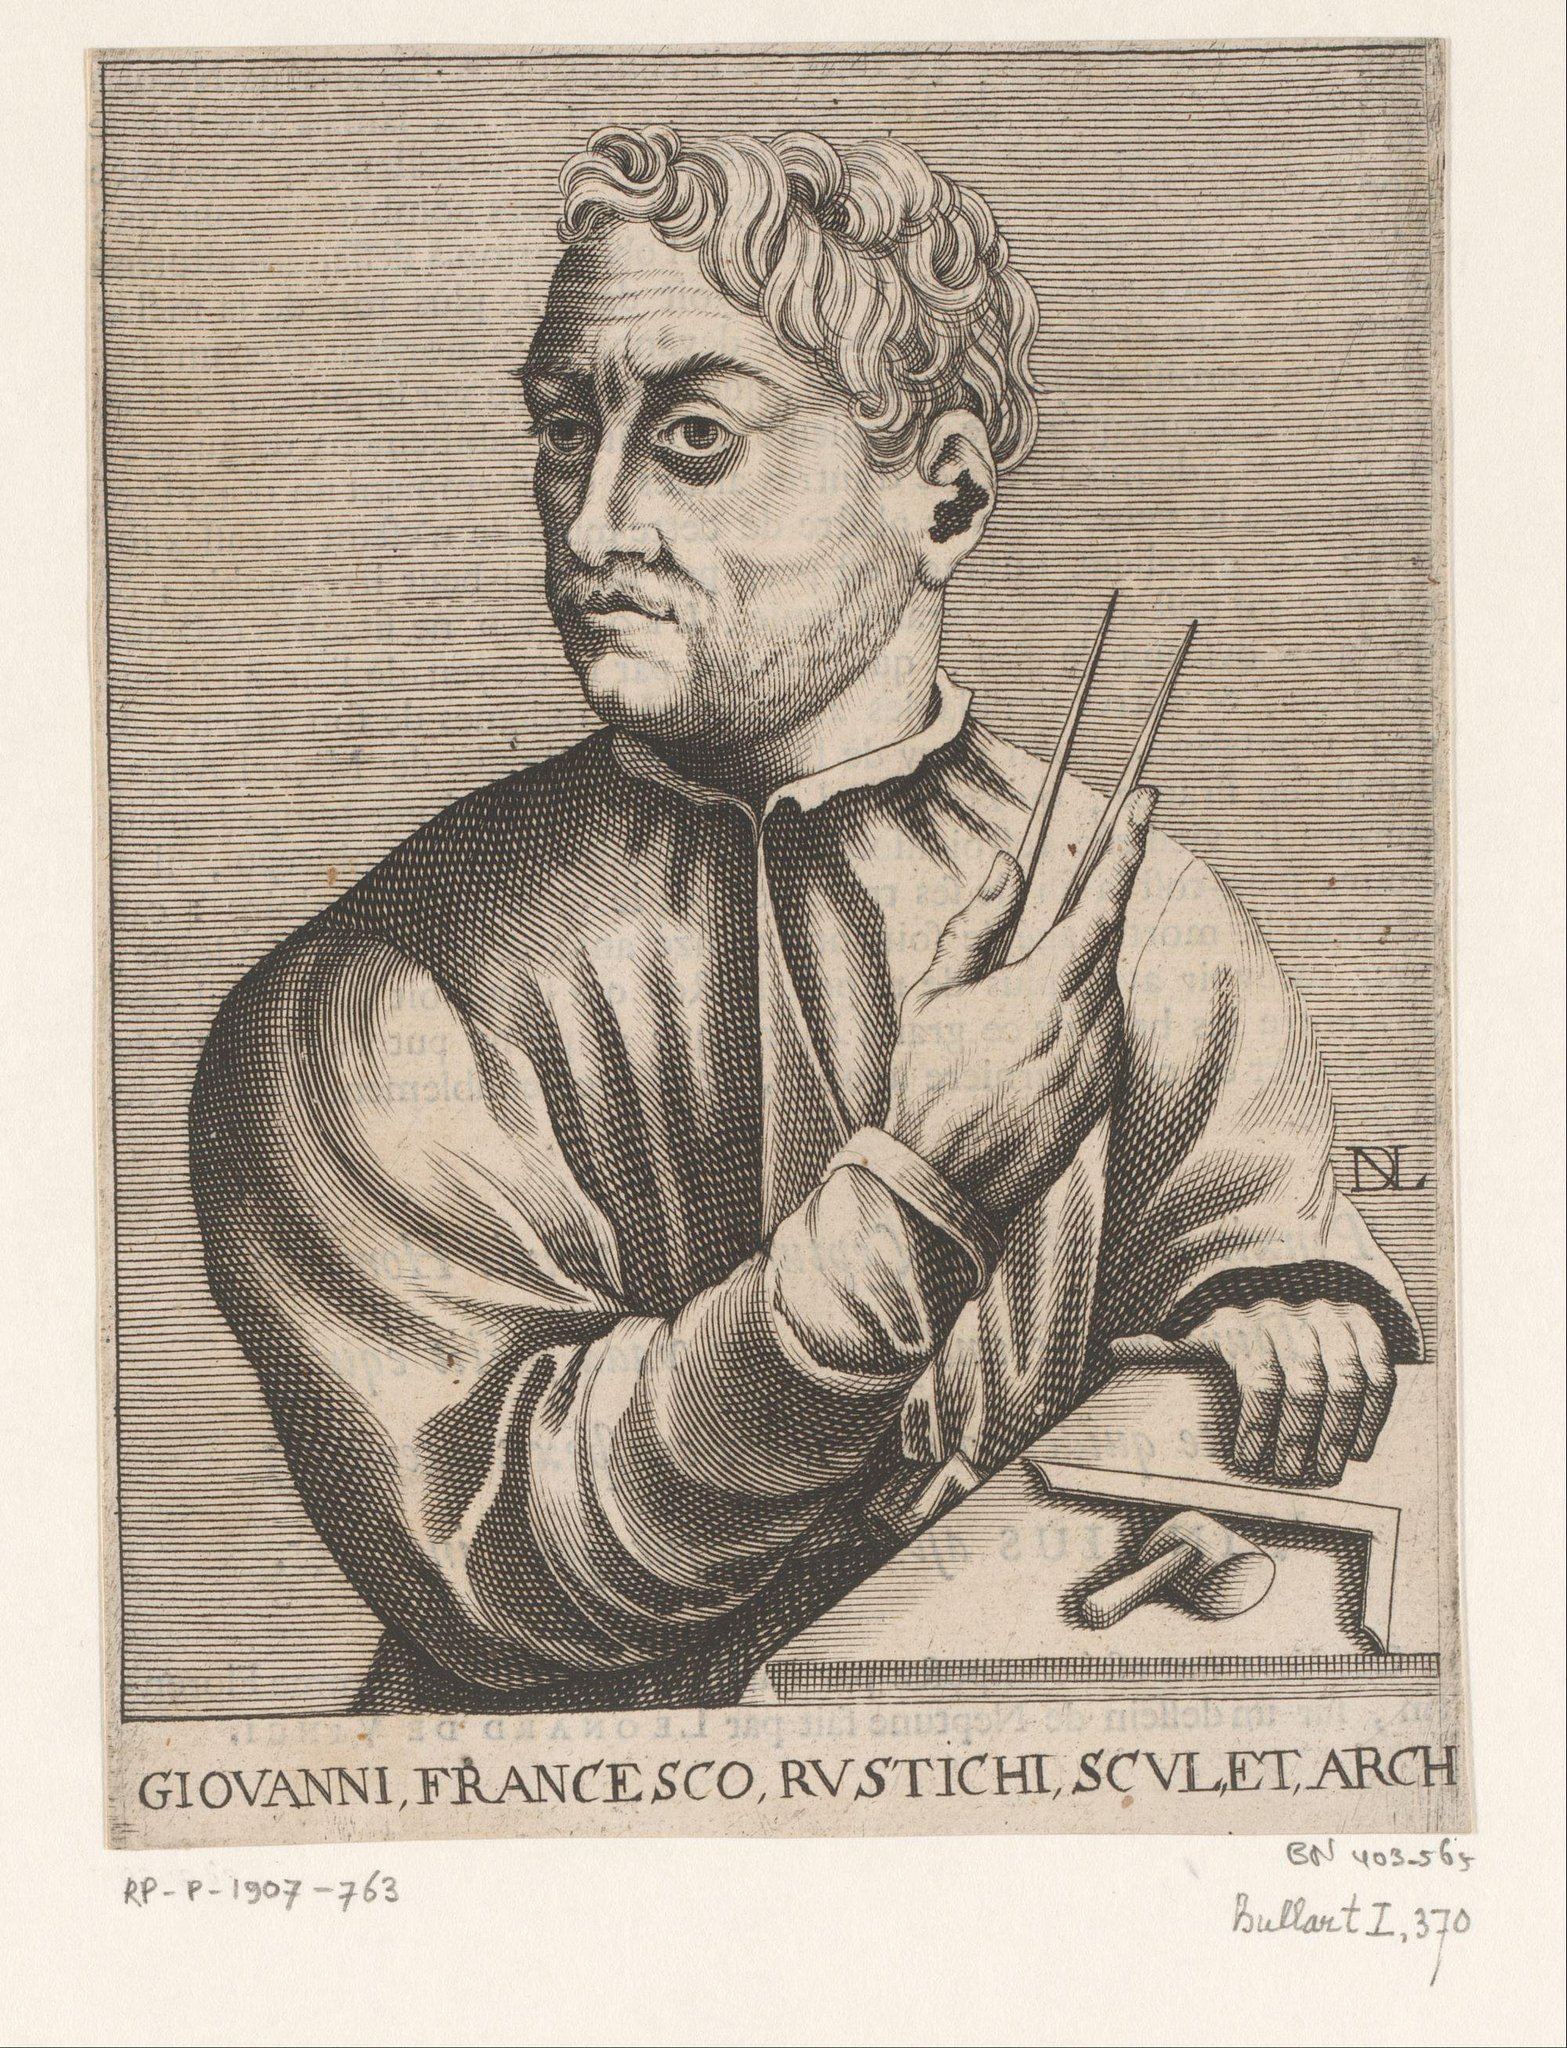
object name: print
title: Portret van Gianfrancesco Rustici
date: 1682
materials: paper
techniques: engraving, letterpress printing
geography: brussels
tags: painter, draughtsman, sculptor, gianfrancesco rustici, portrait, self-portrait of sculptor, historical persons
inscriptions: collector's mark: Lugt 2228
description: Prent gebruikt voor: Bullart, Isaac. Académie des Sciences et Arts contenant les vies et éloges his. des hommes illustres qui ont excellé en ces professions depuis environ quatre siècles. Brussel: François Foppens, 1682. Het boek werd in 1682 eveneens in Amsterdam uitgegeven door de erfgenamen van Daniel Elzevier. Ieder portret betreft een illustratie bij de biografie van een kunstenaar of geleerde. De meeste portretten werden door Nicolas de Larmessin vervaardigd (162), 93 door De Boulonois en een derde door ongeïdentificeerde prentmakers. Dit betreft een illustratie op p. 370, deel I.